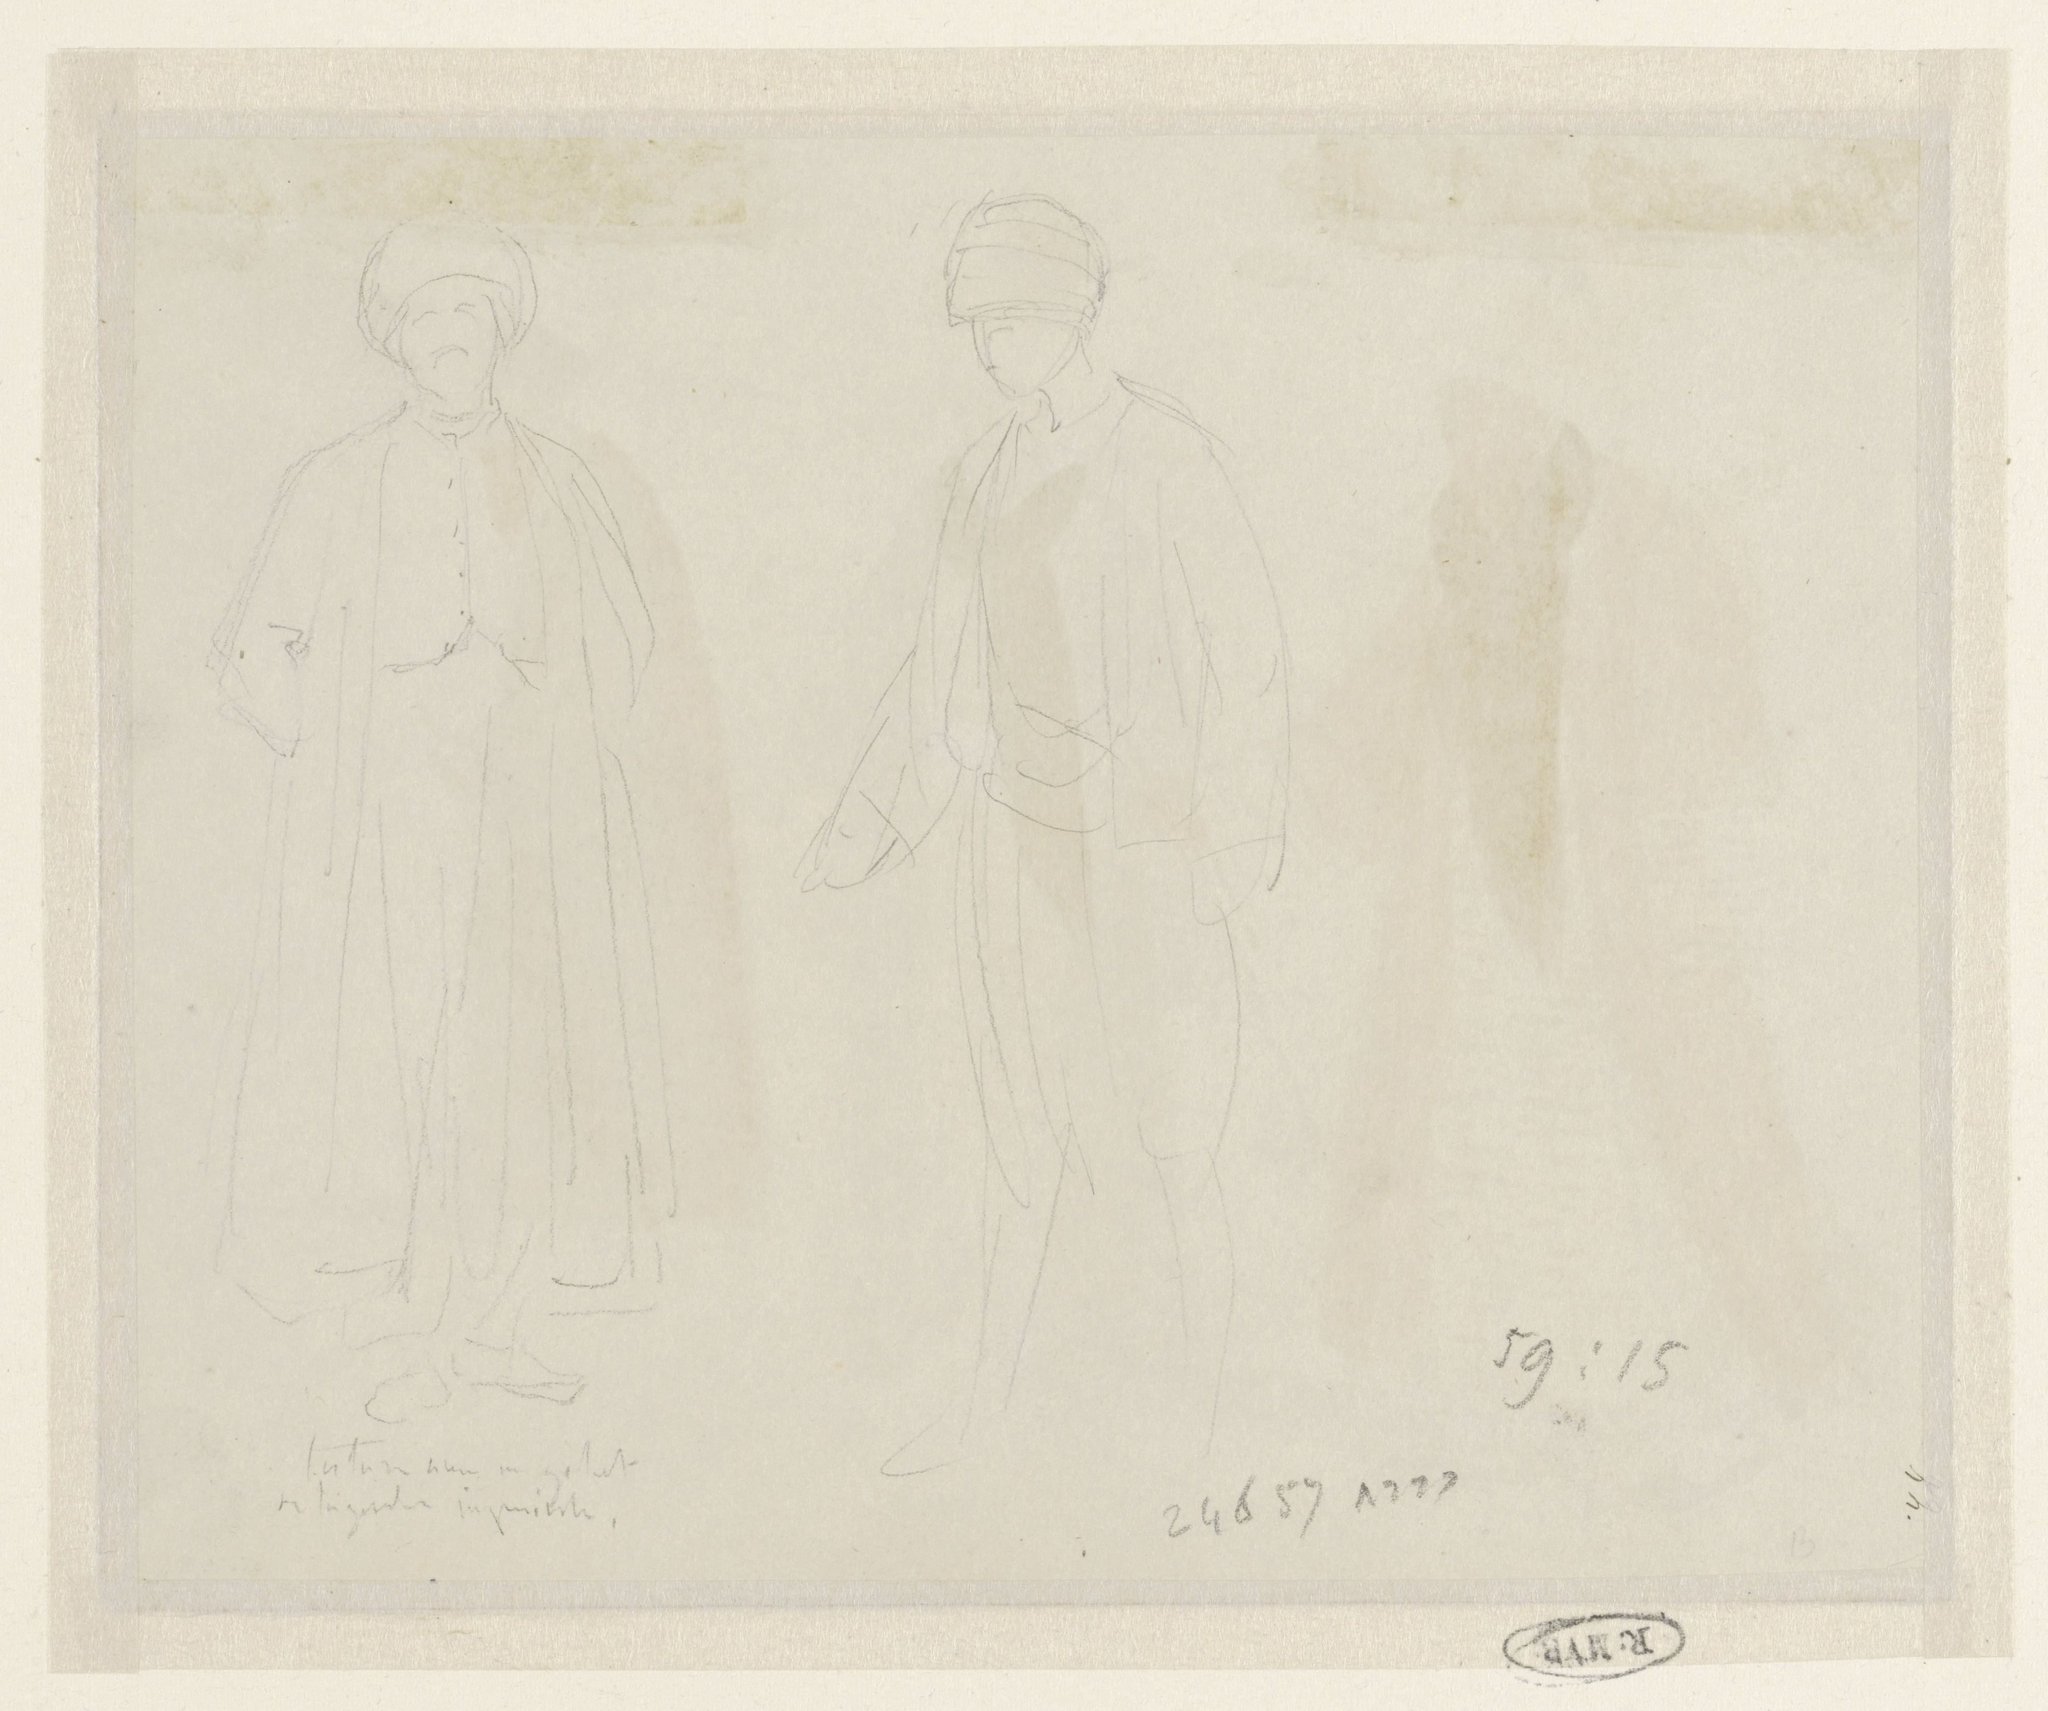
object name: drawing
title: Schetsen van twee Tataren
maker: denis auguste marie raffet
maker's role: draughtsman, print maker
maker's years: 1804-1860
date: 1832-1842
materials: paper, pencil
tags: folk costume, regional costume, asiatic races and peoples (tatars)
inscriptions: date